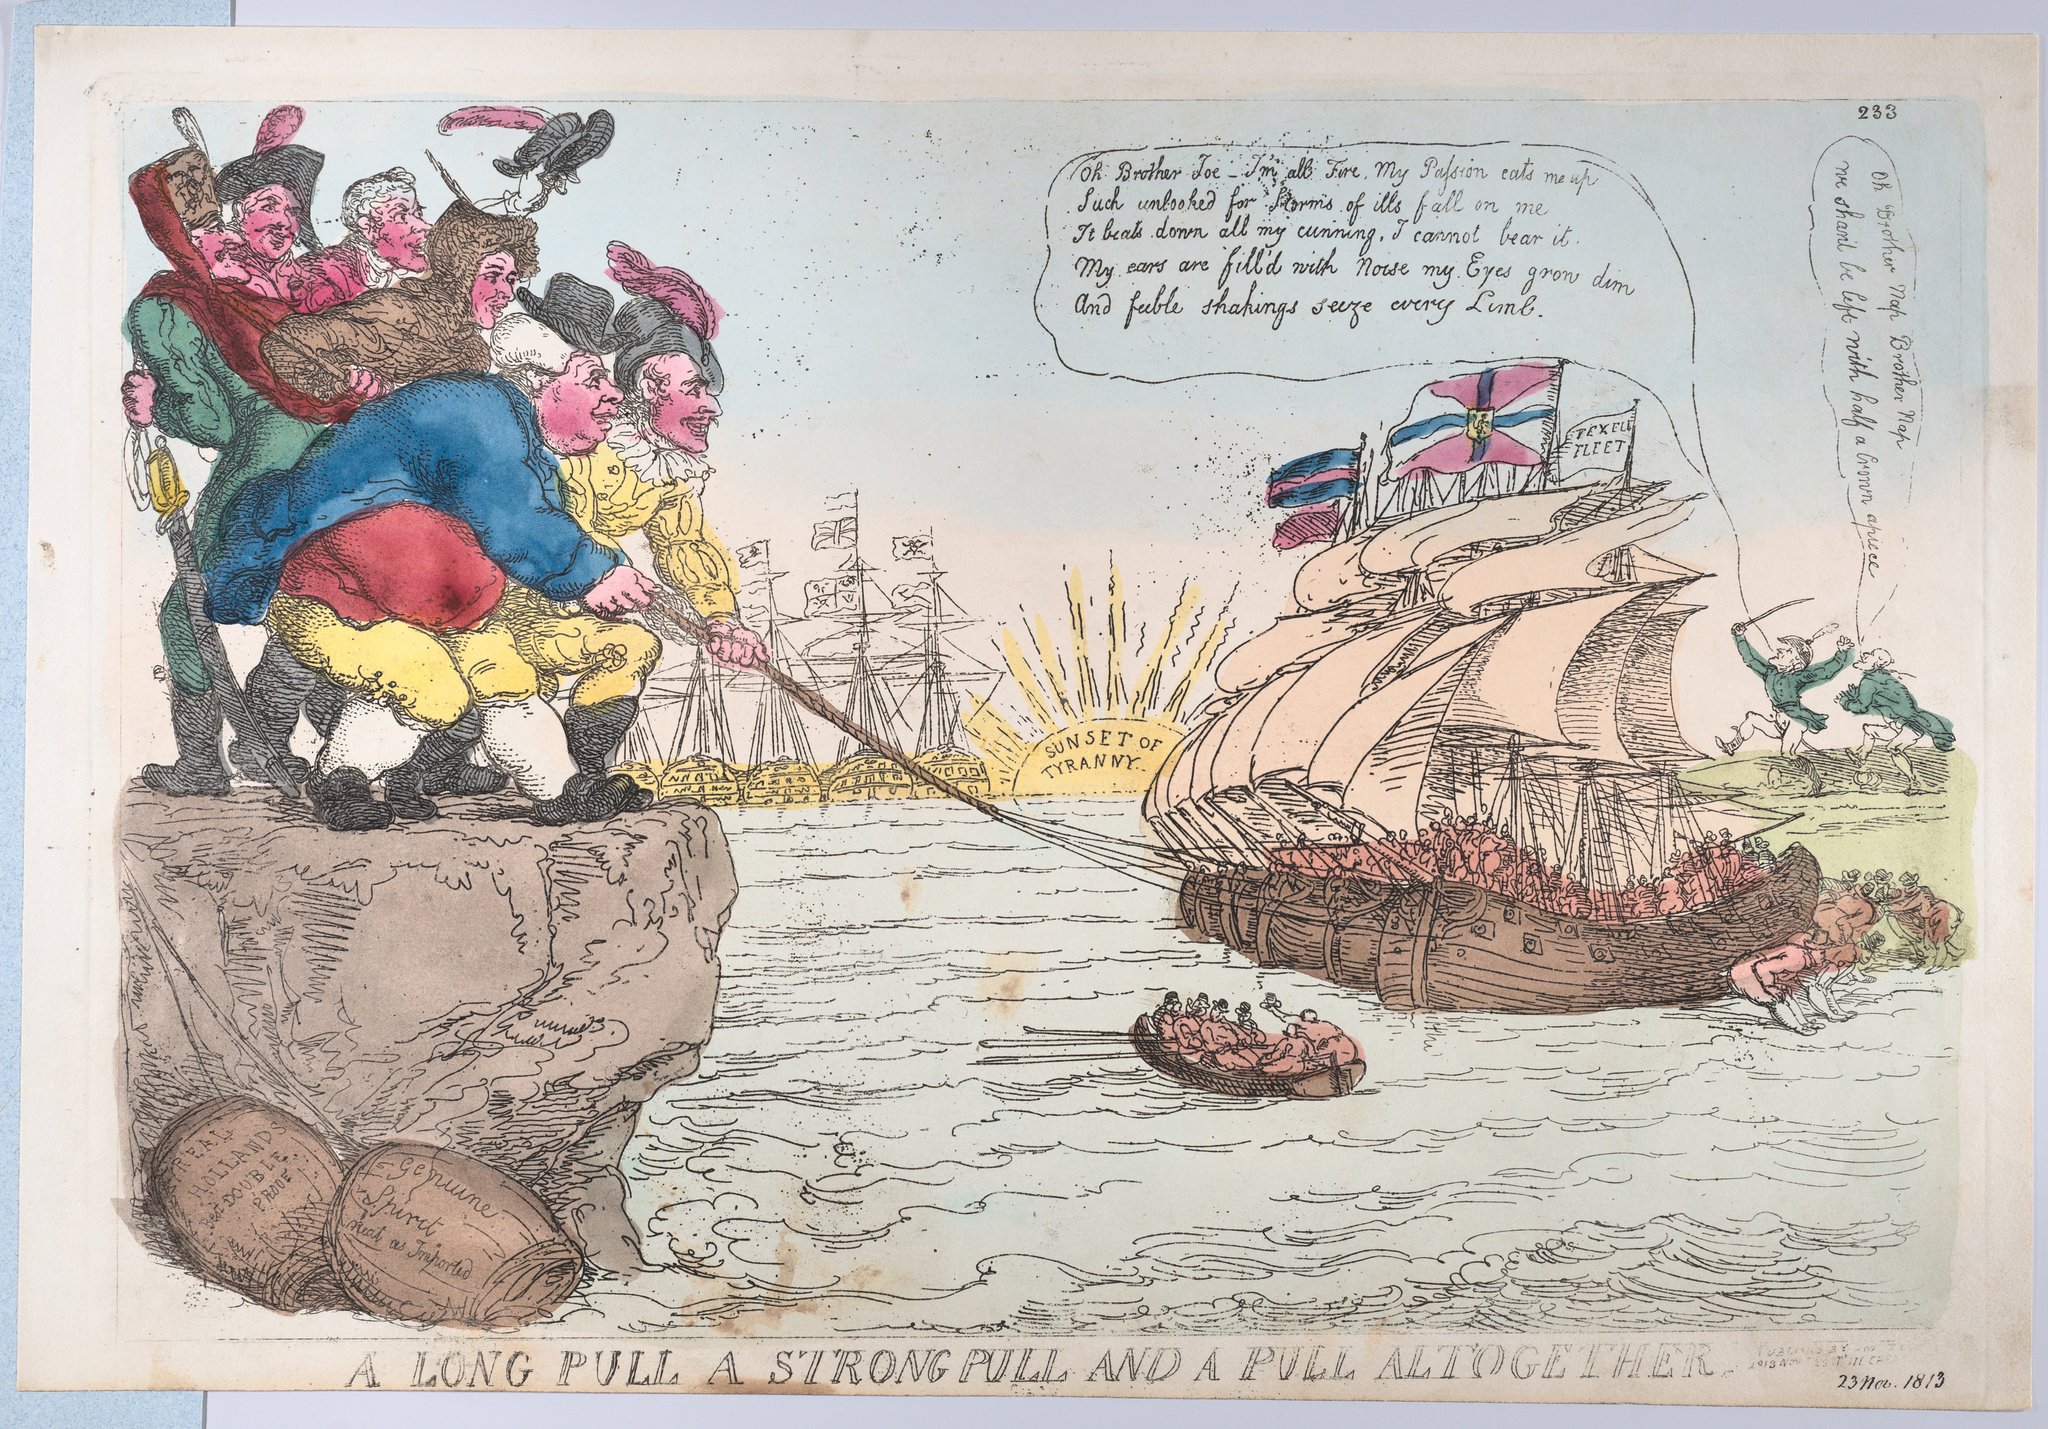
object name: print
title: A Long Pull A Strong Pull and a Pull Altogether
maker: thomas rowlandson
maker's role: artist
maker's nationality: british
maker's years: 1757-1827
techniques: etching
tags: satire,napoleon i,men,ships,politics